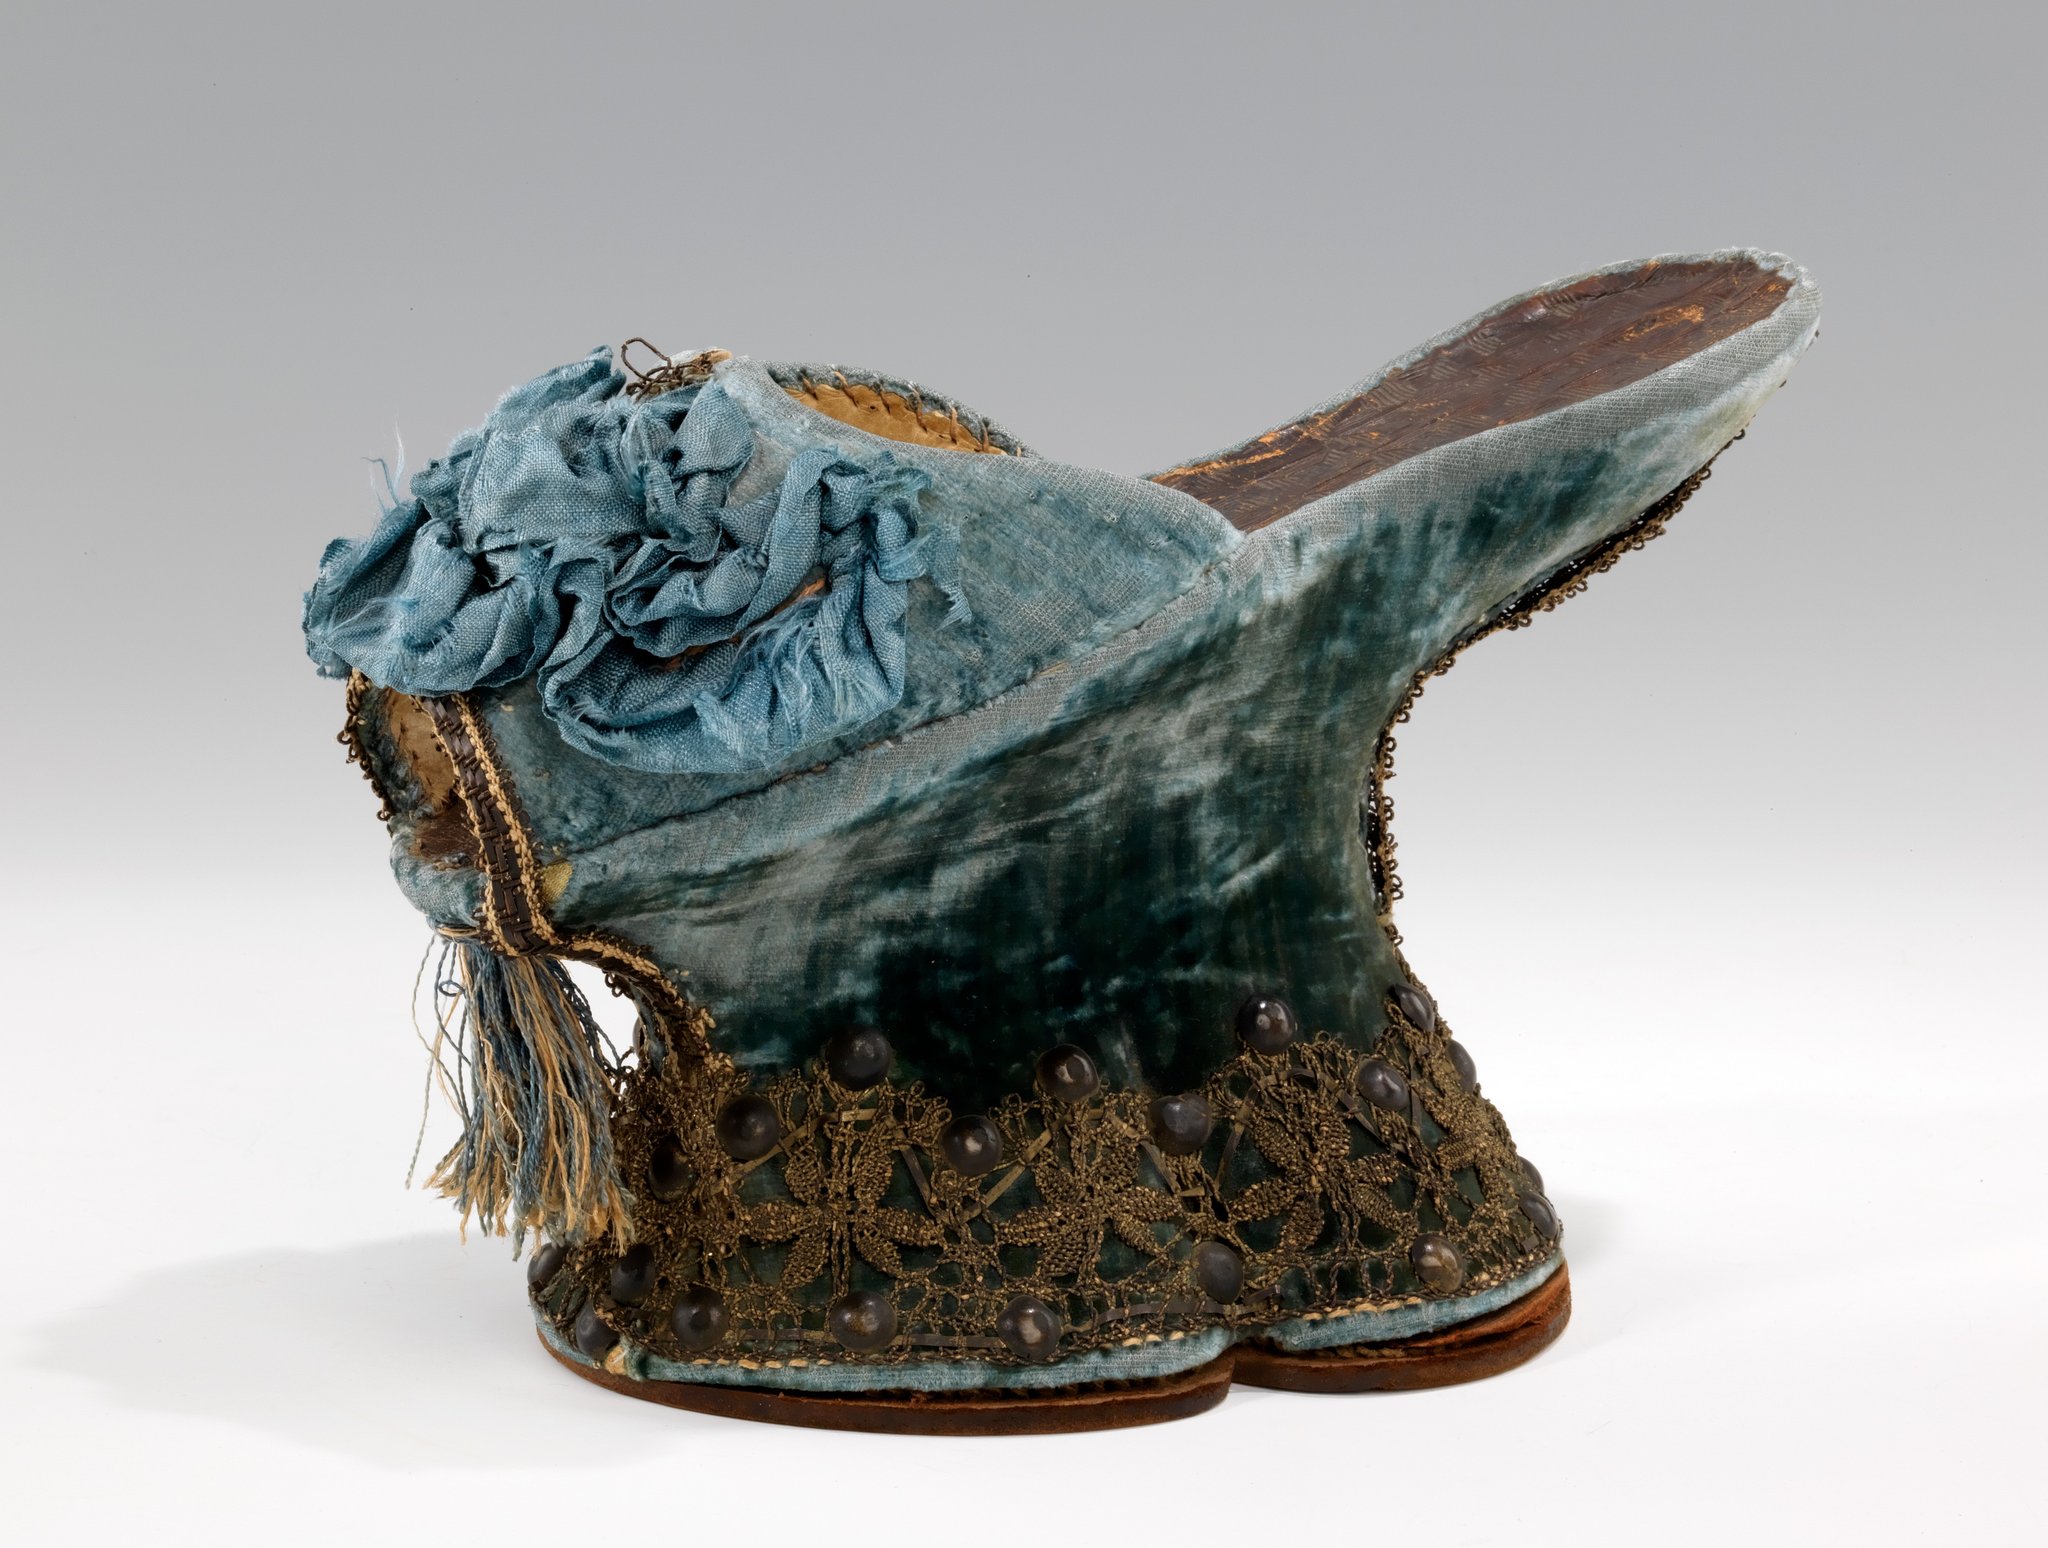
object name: chopine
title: Chopines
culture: italian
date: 1590-1610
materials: metal, silk